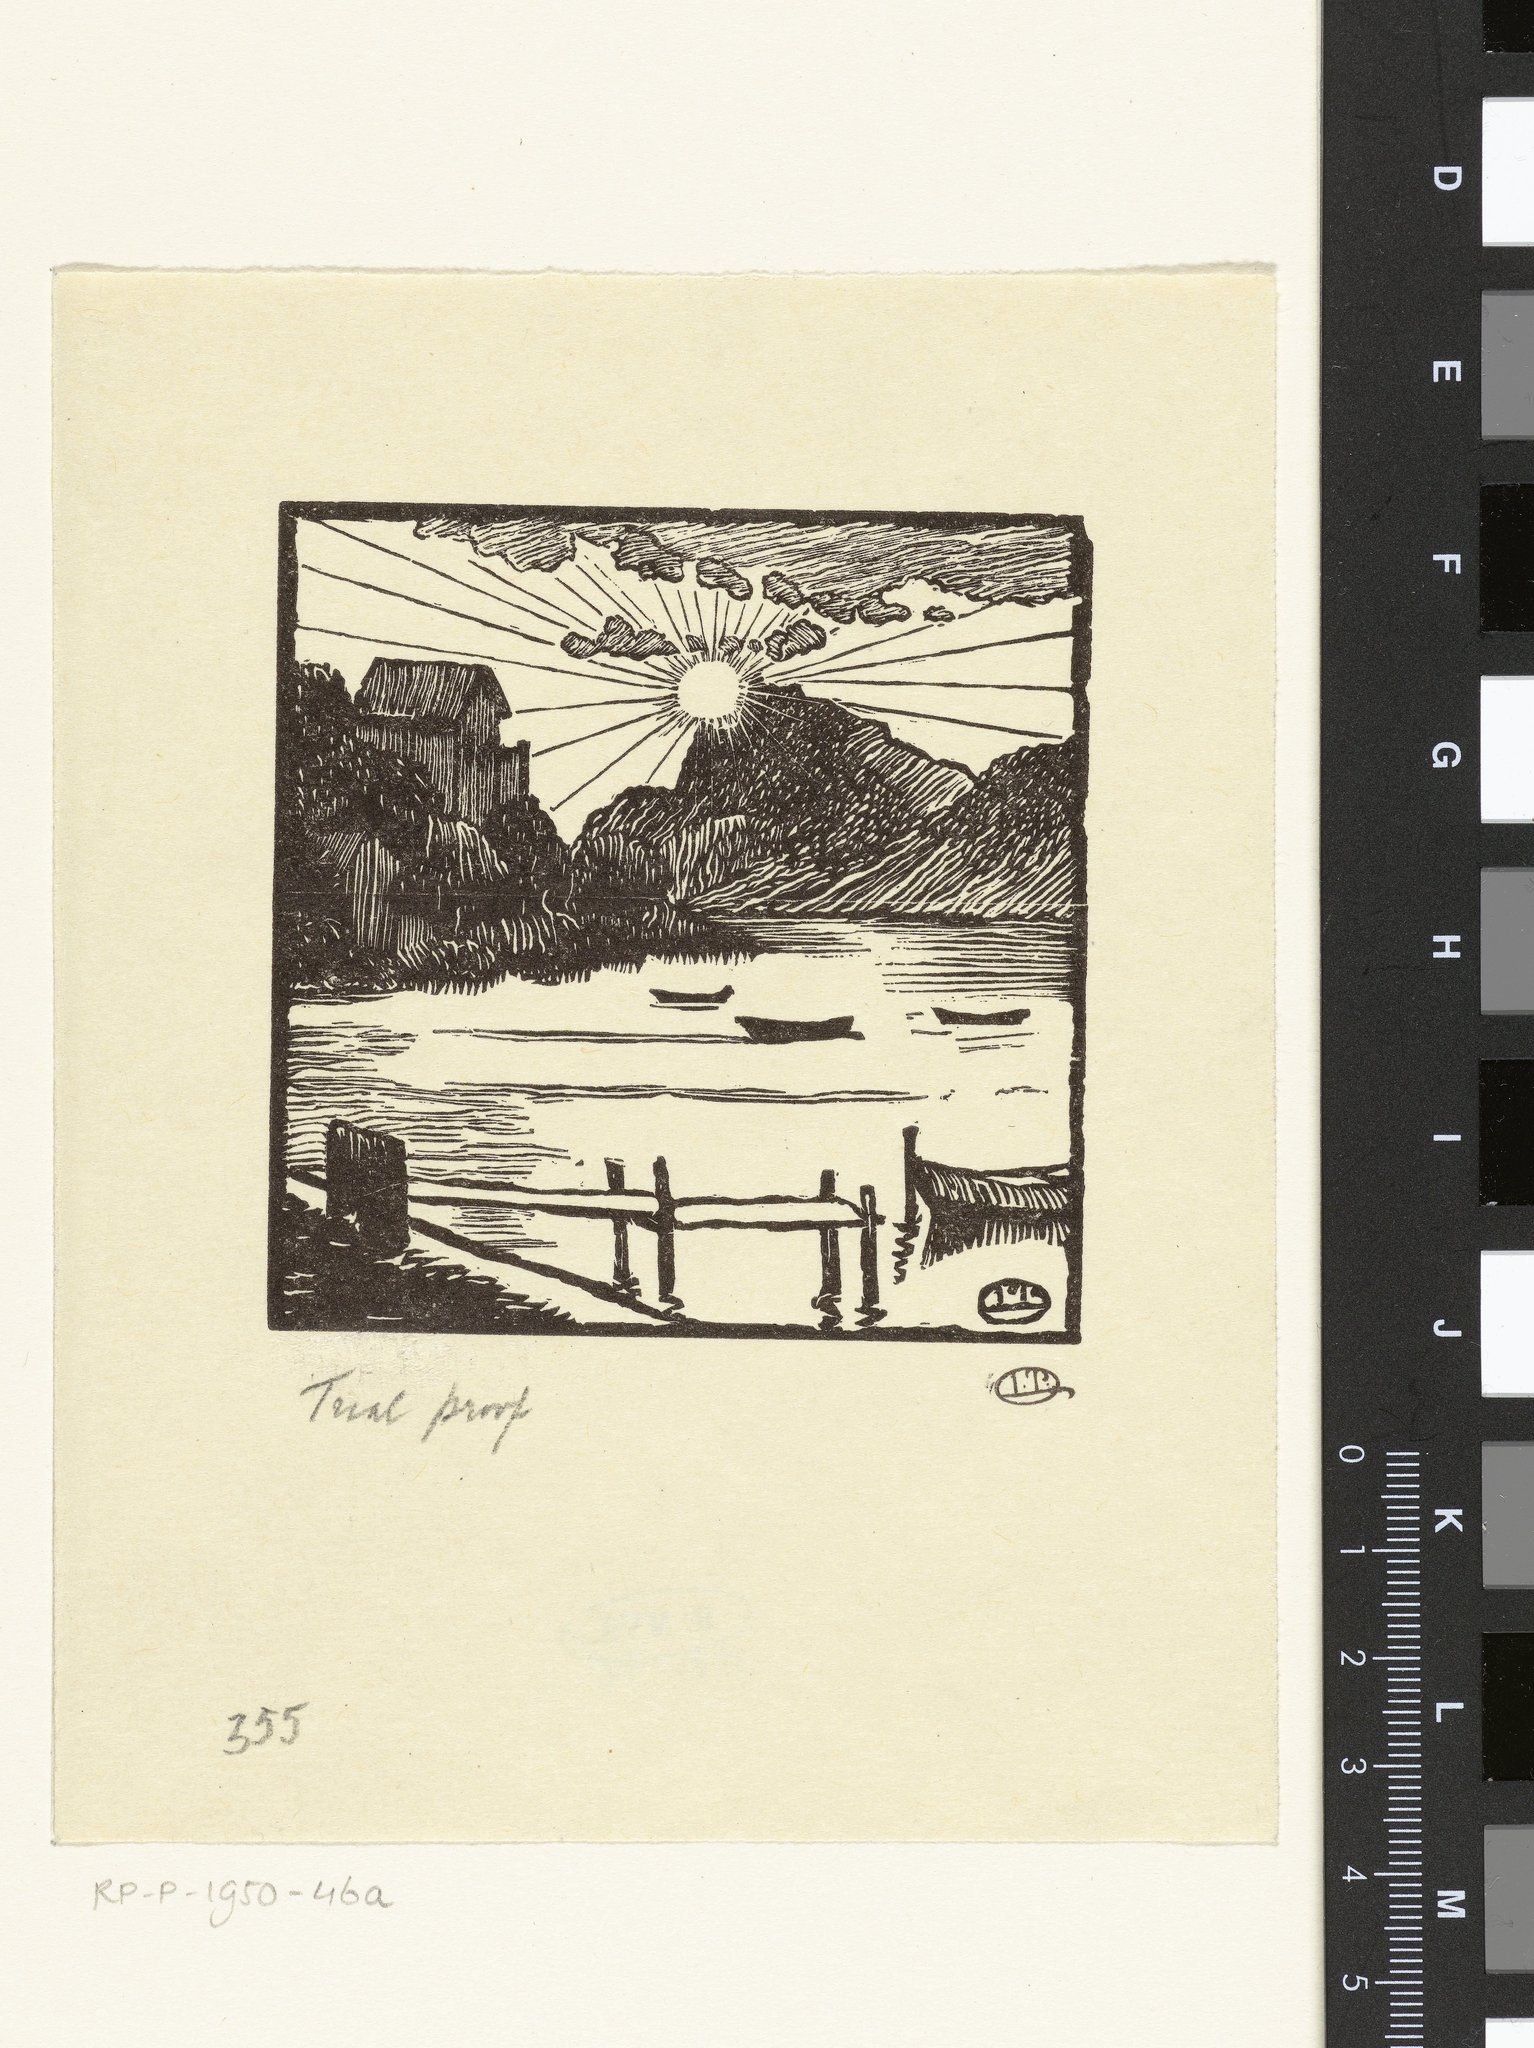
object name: print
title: La Pointe de Caugaussa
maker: lucien pissarro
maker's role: painter, print maker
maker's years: 1863-1944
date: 1927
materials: paper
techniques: engraving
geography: hammersmith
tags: lake, sunrise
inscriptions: collector's mark: Lugt 2228, stamp: Lugt 1756b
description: Landschap met een zonsopgang bij een meer.